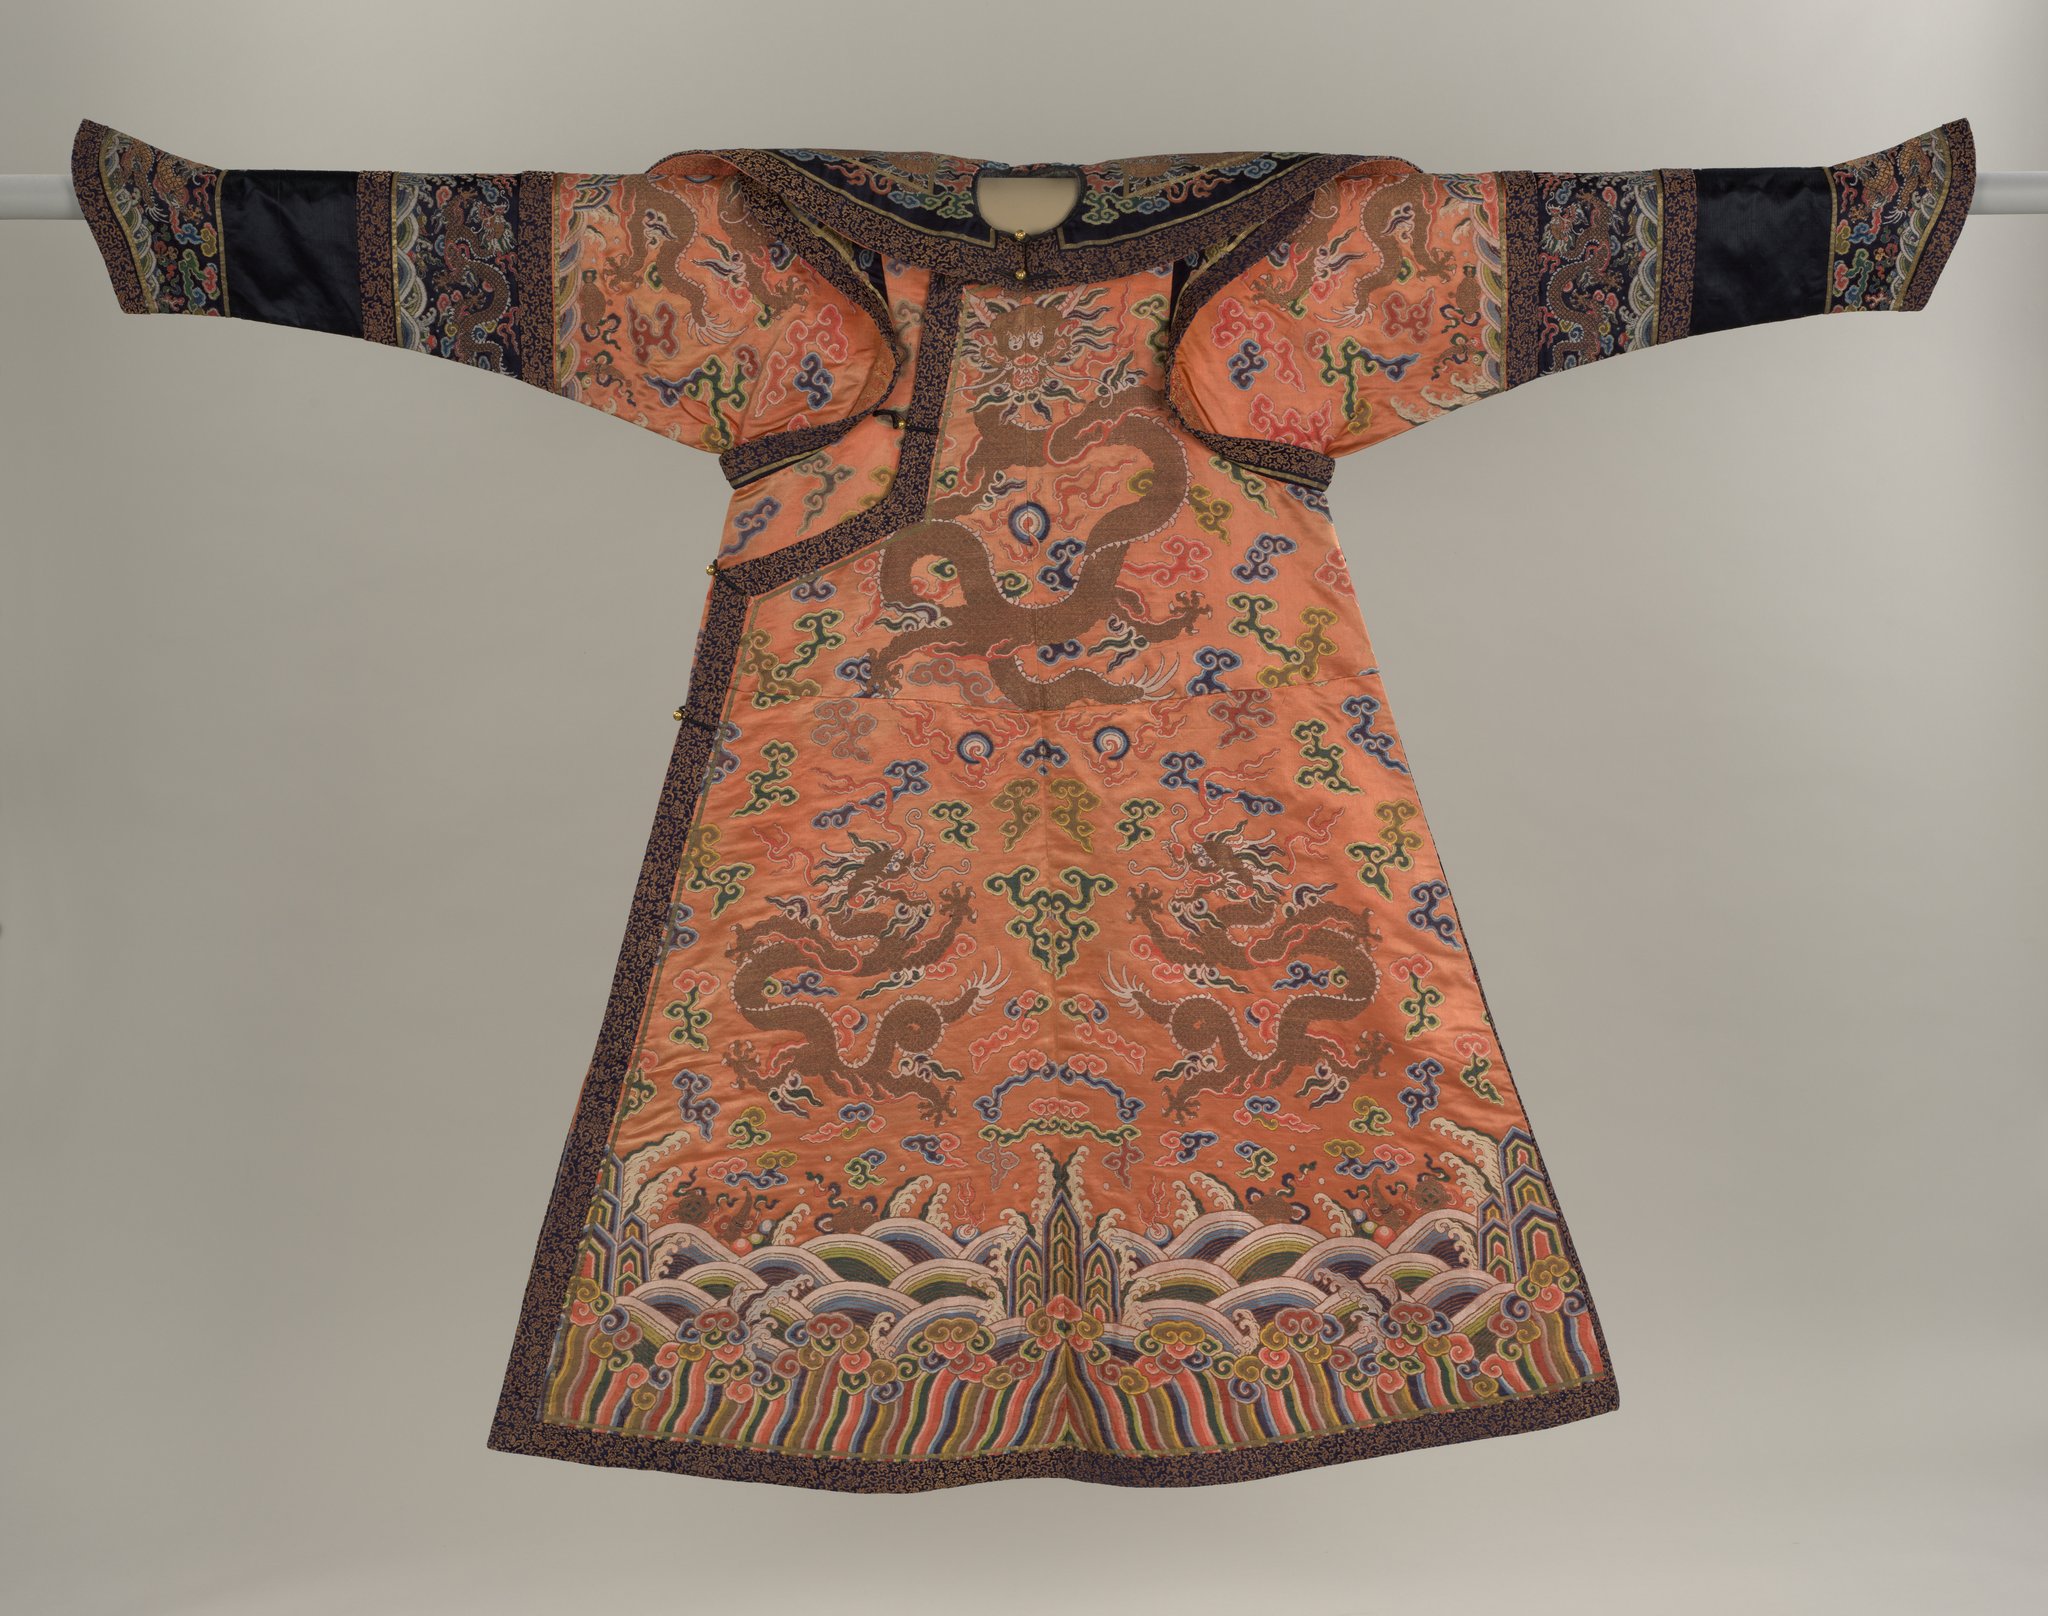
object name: robe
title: Woman's Robe of State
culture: chinese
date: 1701-1800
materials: metal thread, silk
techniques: embroidery, satin weave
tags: dragons